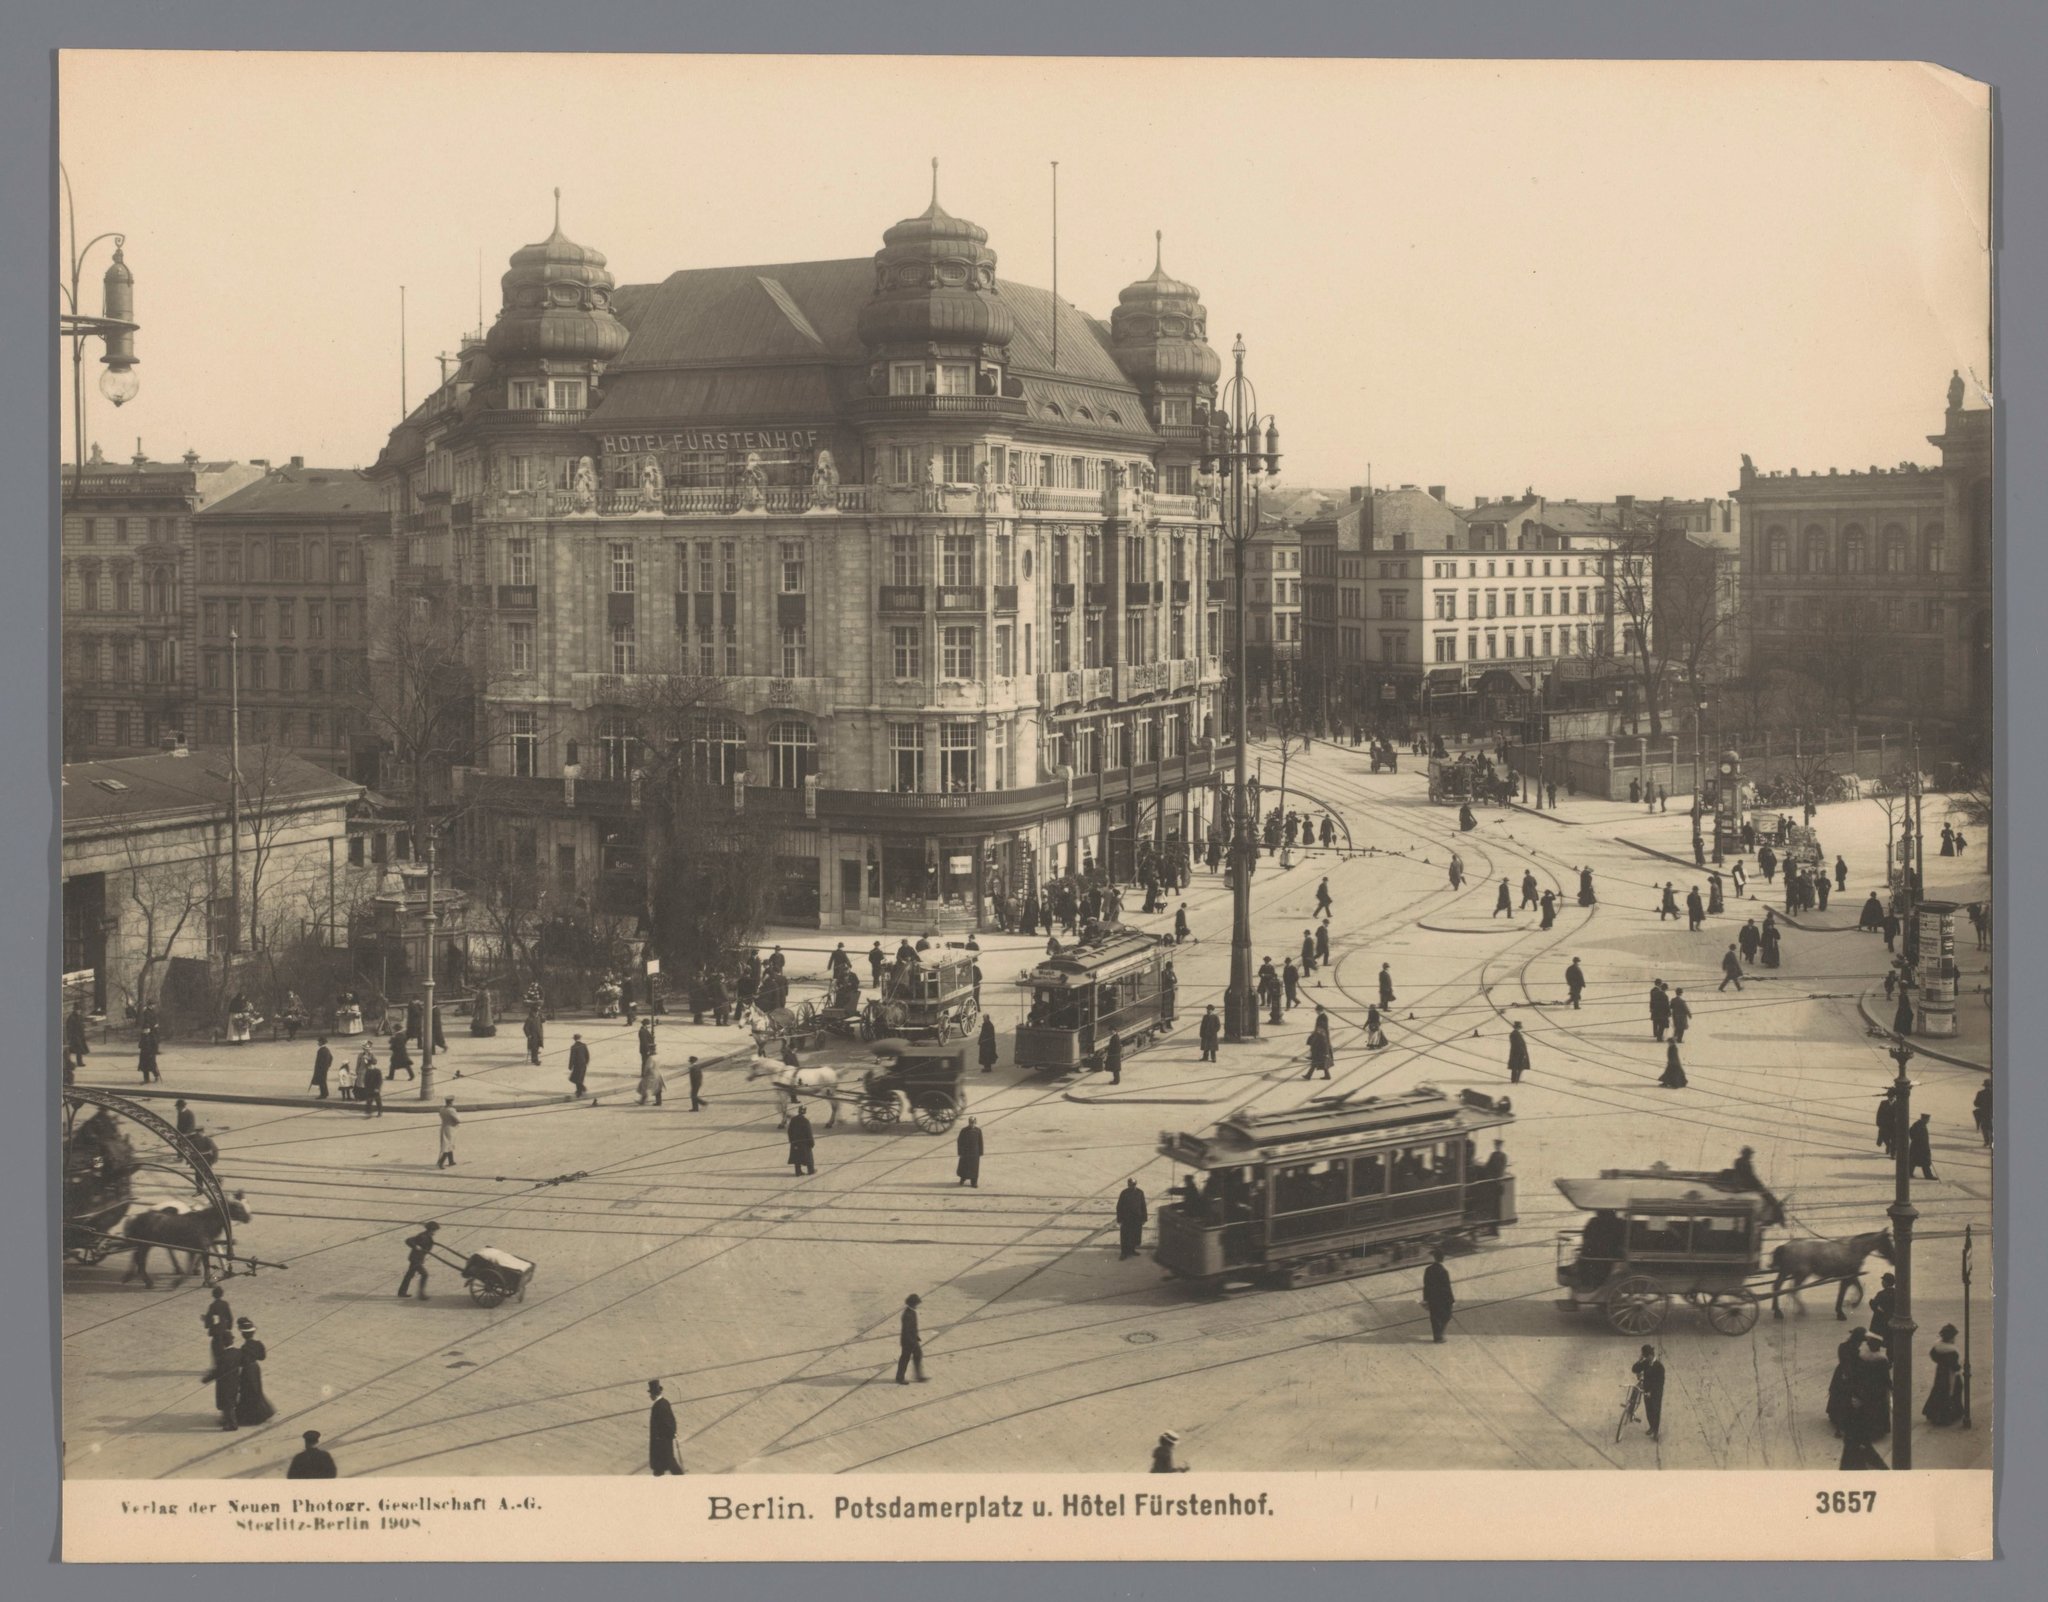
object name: photograph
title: Berlin. Potsdamerplatz u. Hôtel Fürstenhof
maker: Anonymous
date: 1908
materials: paper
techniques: gelatin silver print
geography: berlin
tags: square, place, circus, etc.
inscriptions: inscription: ‘Verlag der Neuen Photogr. Gesellschaft A.-G./ Steglitz-Berlin 1908/ Berlin. Potsdamerplatz u. Hôtel Fürstenhof/ 3657’